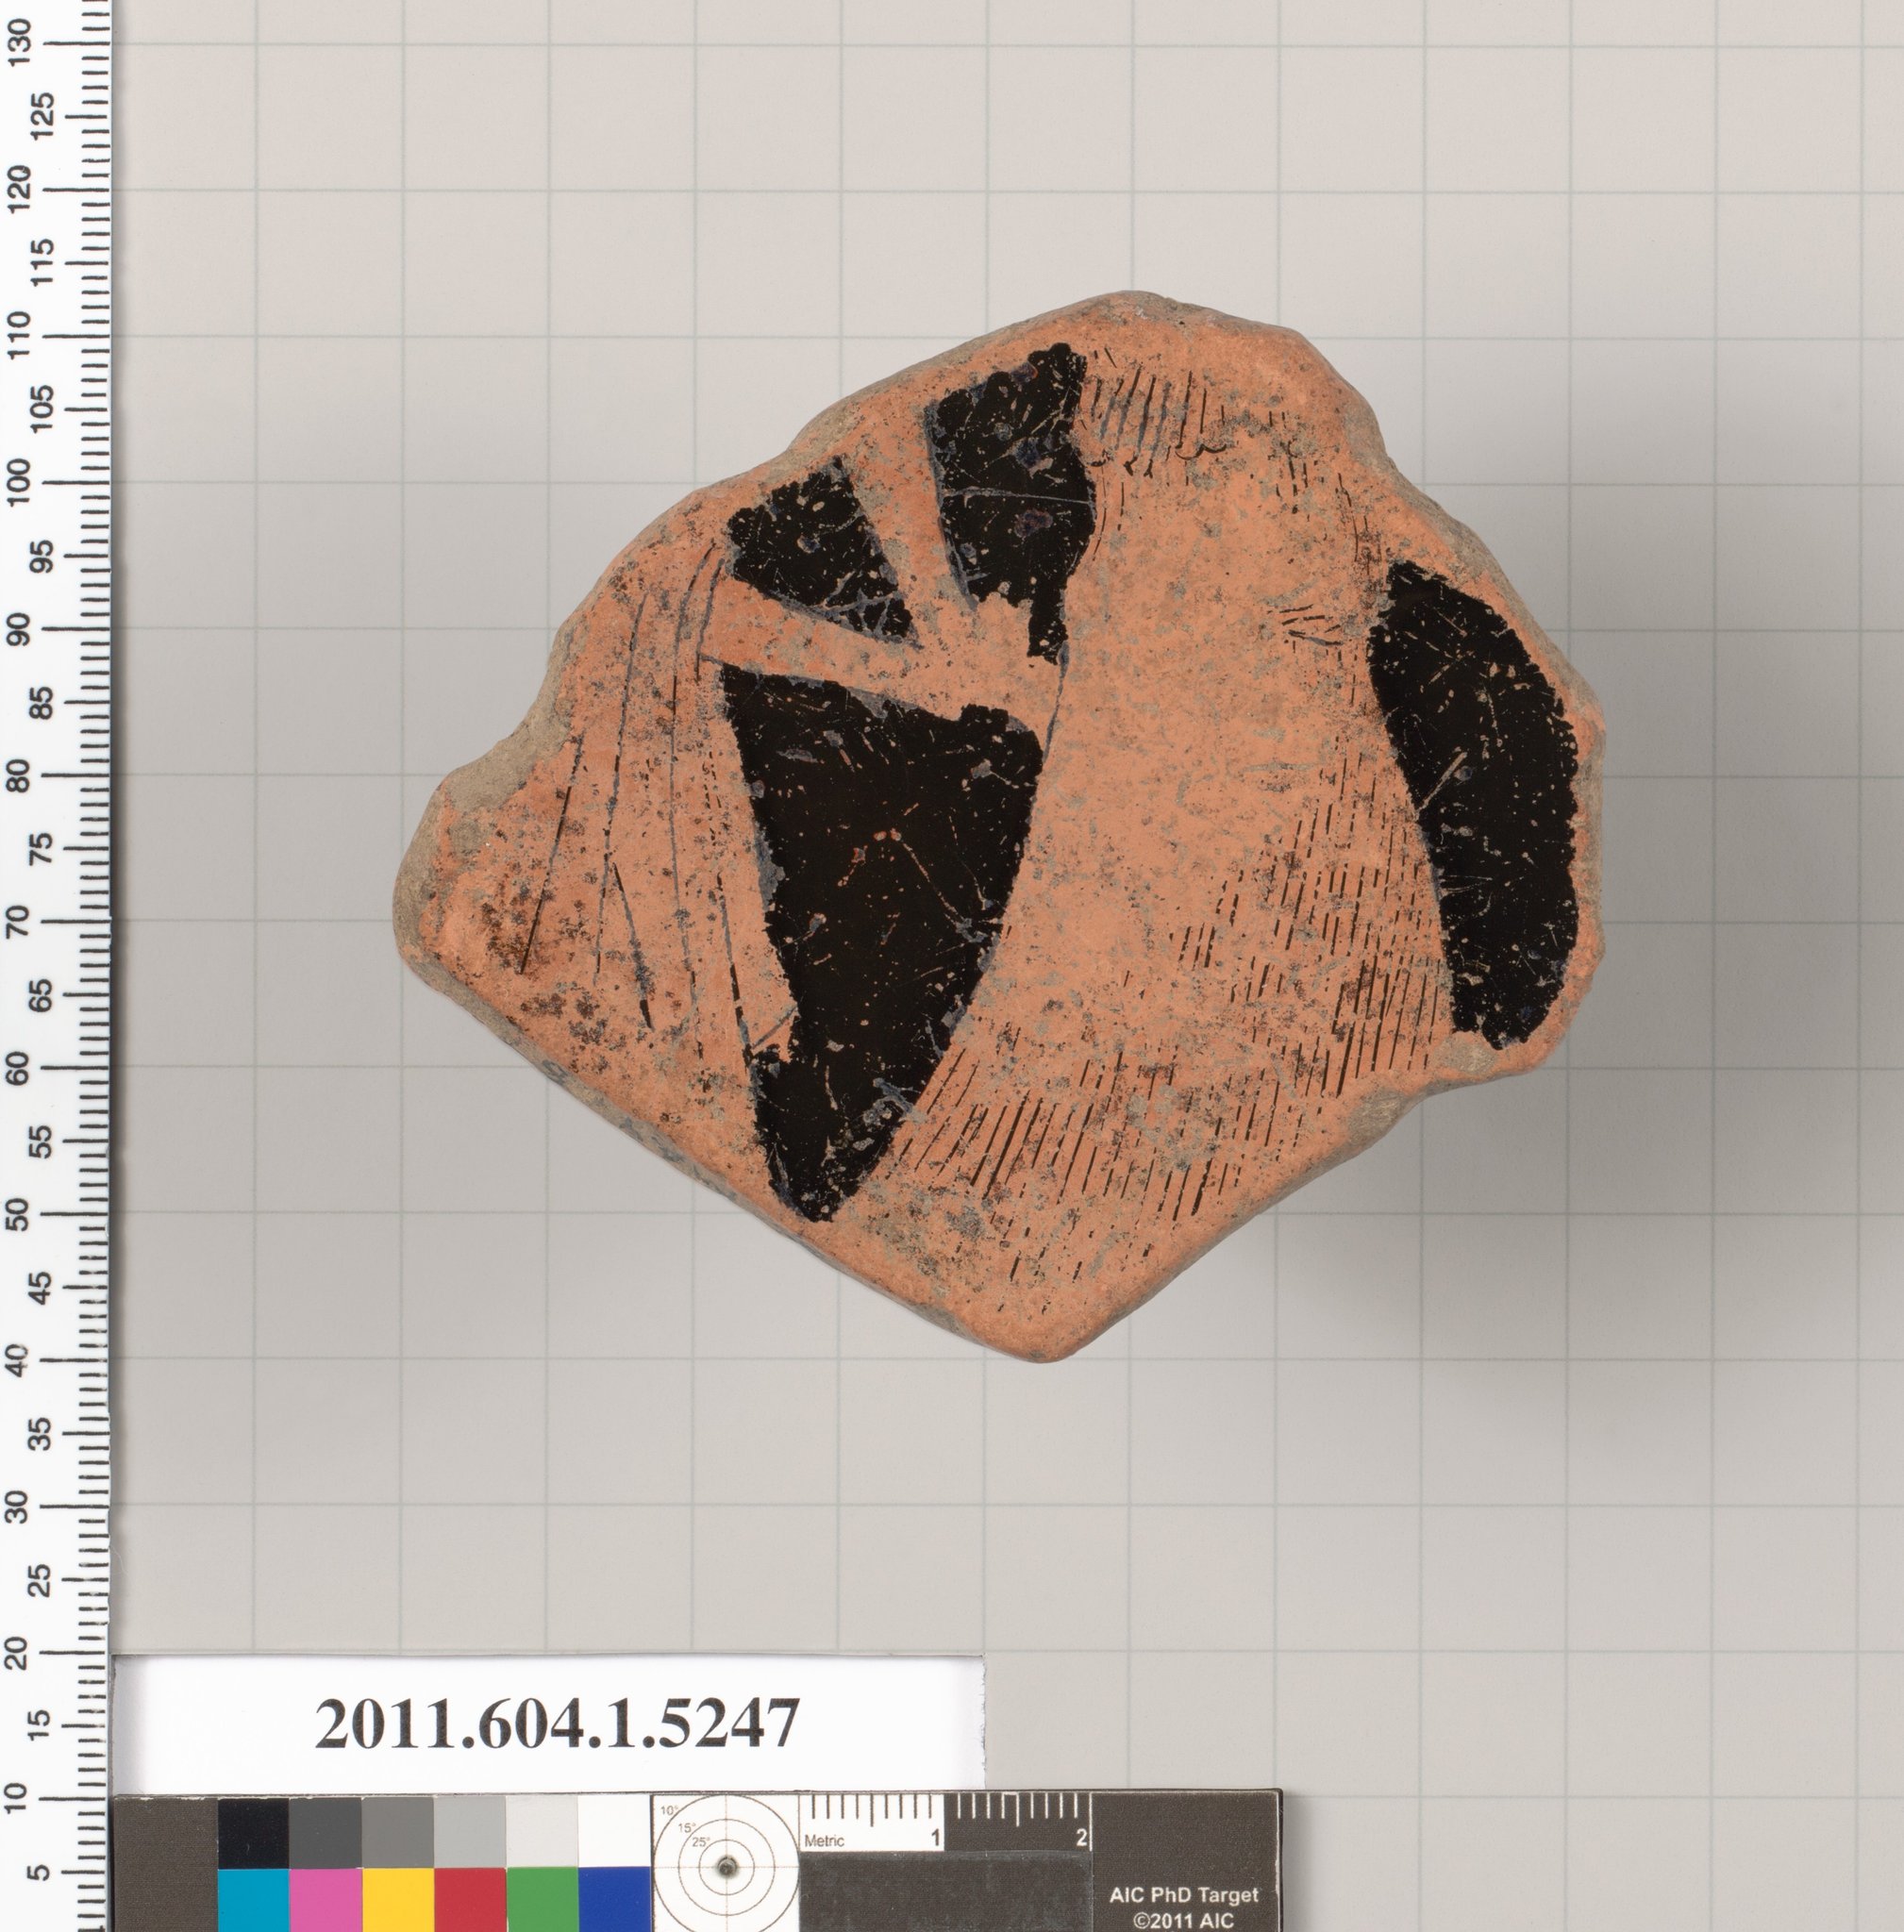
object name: kylix fragment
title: Terracotta fragment of a kylix (drinking cup)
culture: greek, attic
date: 500-480 BCE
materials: terracotta